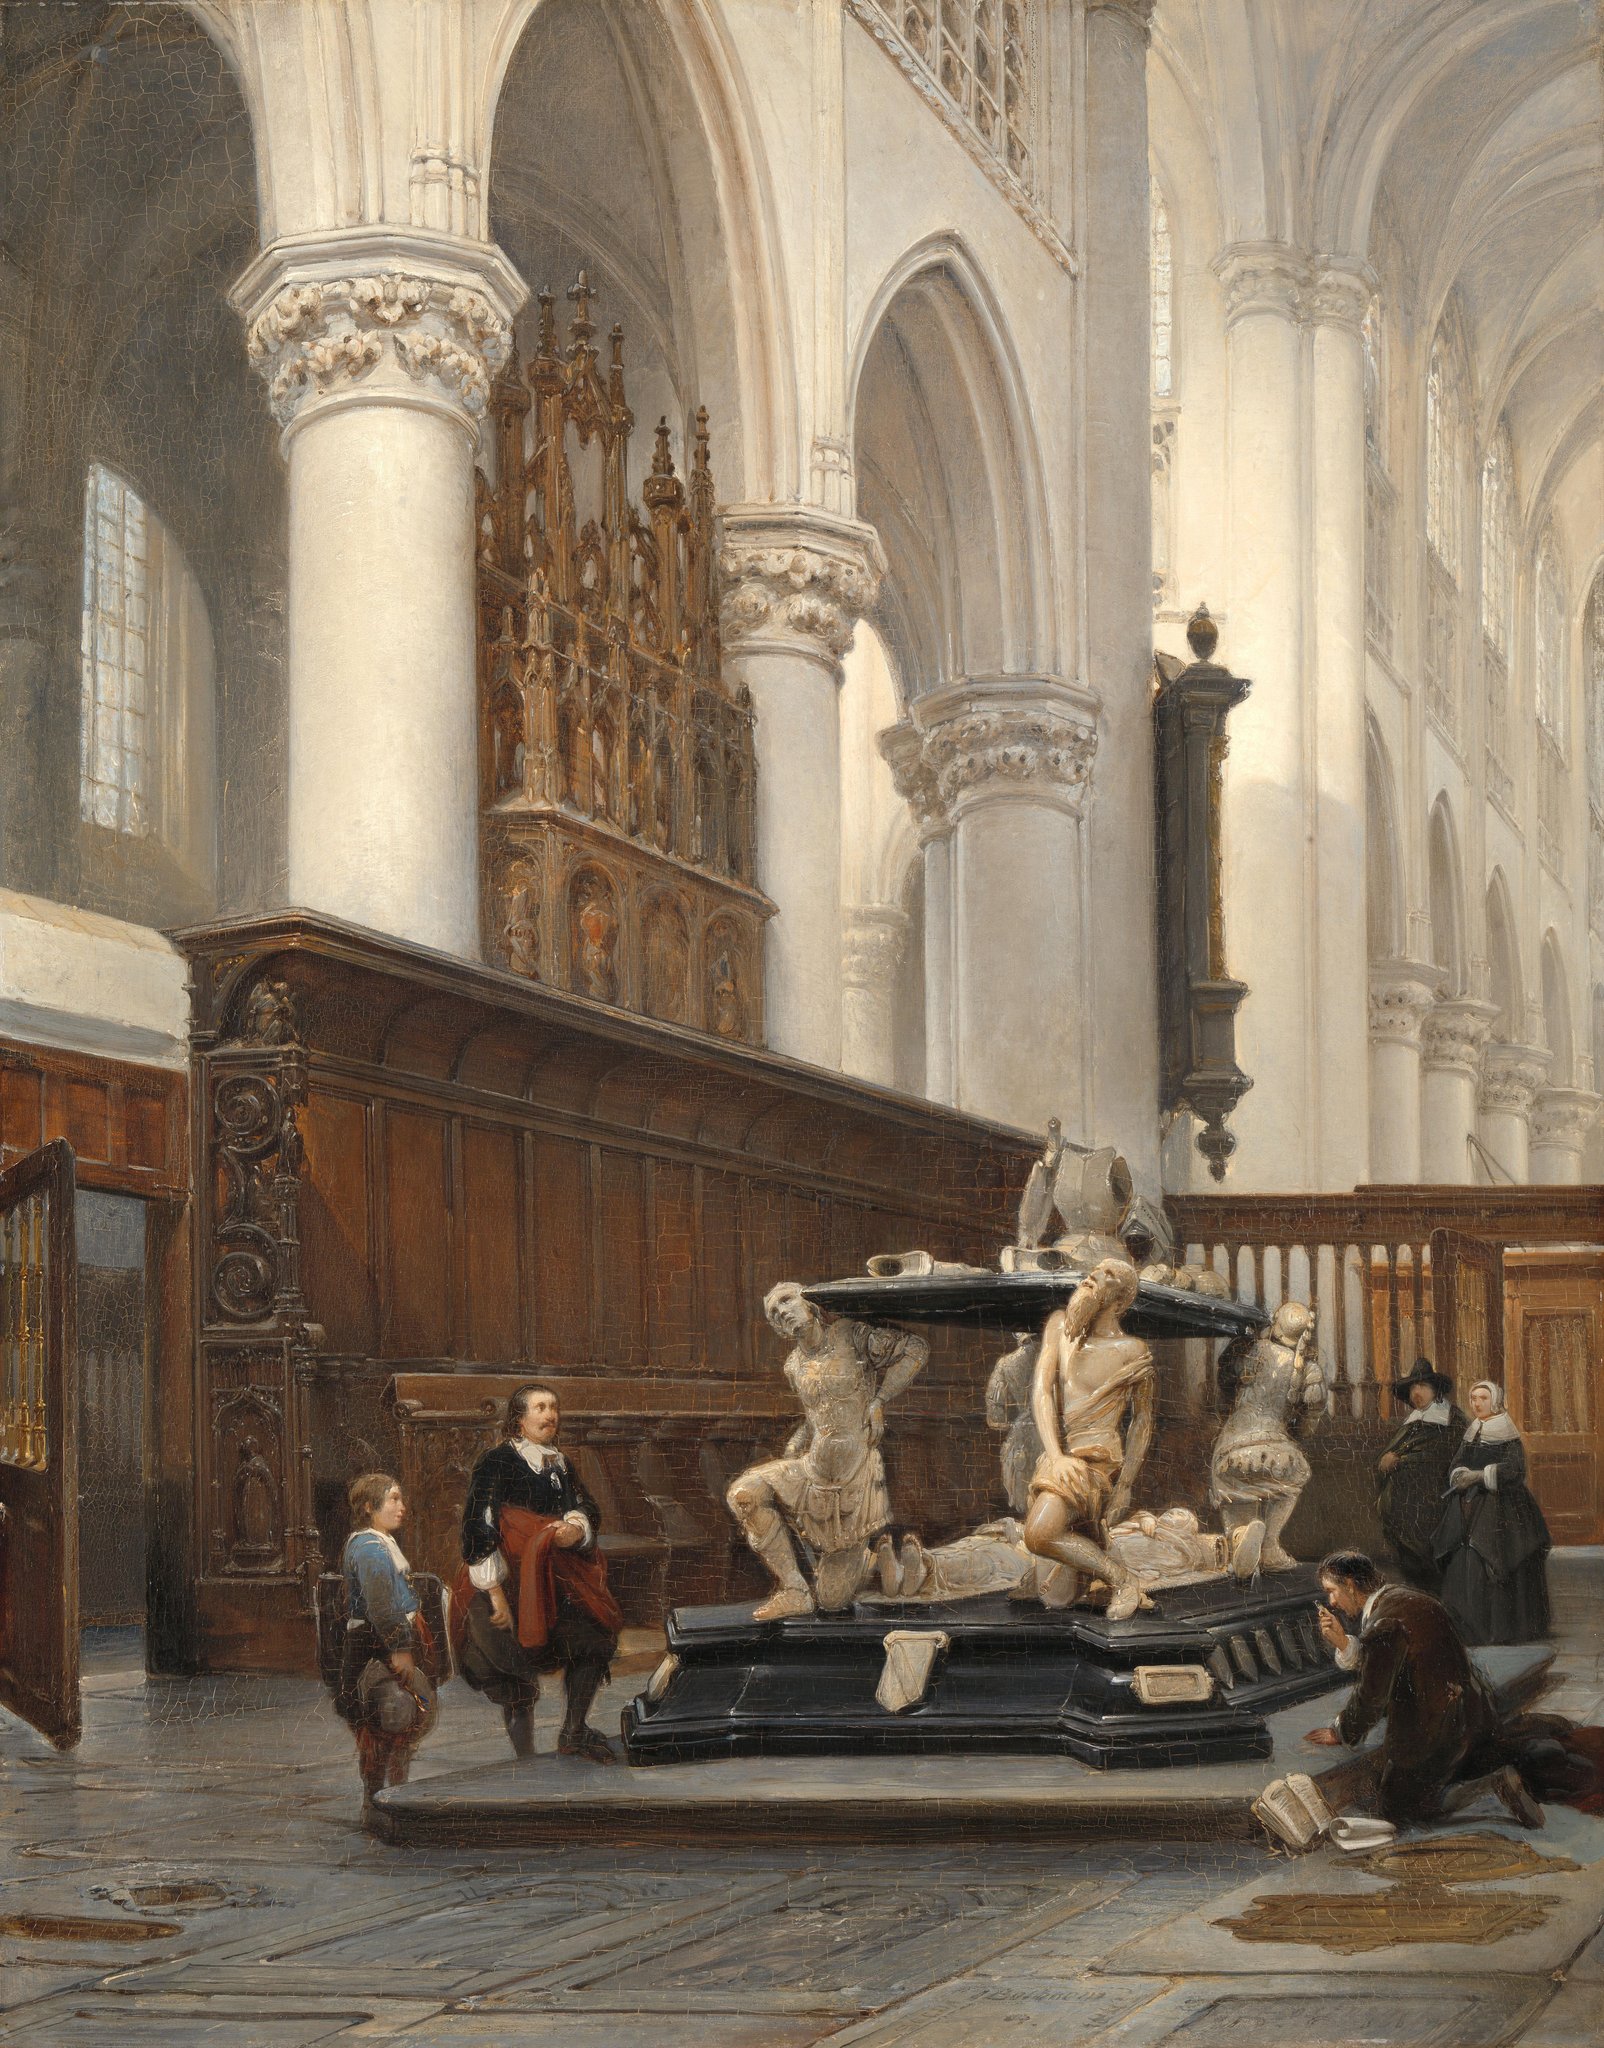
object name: painting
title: The Choir of the Church of Our Lady in Breda with the Tomb of Engelbert II of Nassau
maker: johannes bosboom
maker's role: draughtsman, painter, print maker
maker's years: 1817-1891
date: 1843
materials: oil, panel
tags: brussels, interior of church, grave-building, monumental tomb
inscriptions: signature and date: ‘J. Bosboom 1843’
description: The 15th-century Counts of Nassau were the direct ancestors of King William II. Their tomb in the church of Onze-Lieve-Vrouw in Breda was famous –it was even thought to have been made by Michelangelo. Bosboom painted the figures in 17th-century clothing. At right, a scholar studies the family coats of arms, and at the left an artist admires the monument while his pupil carries his album of drawings.